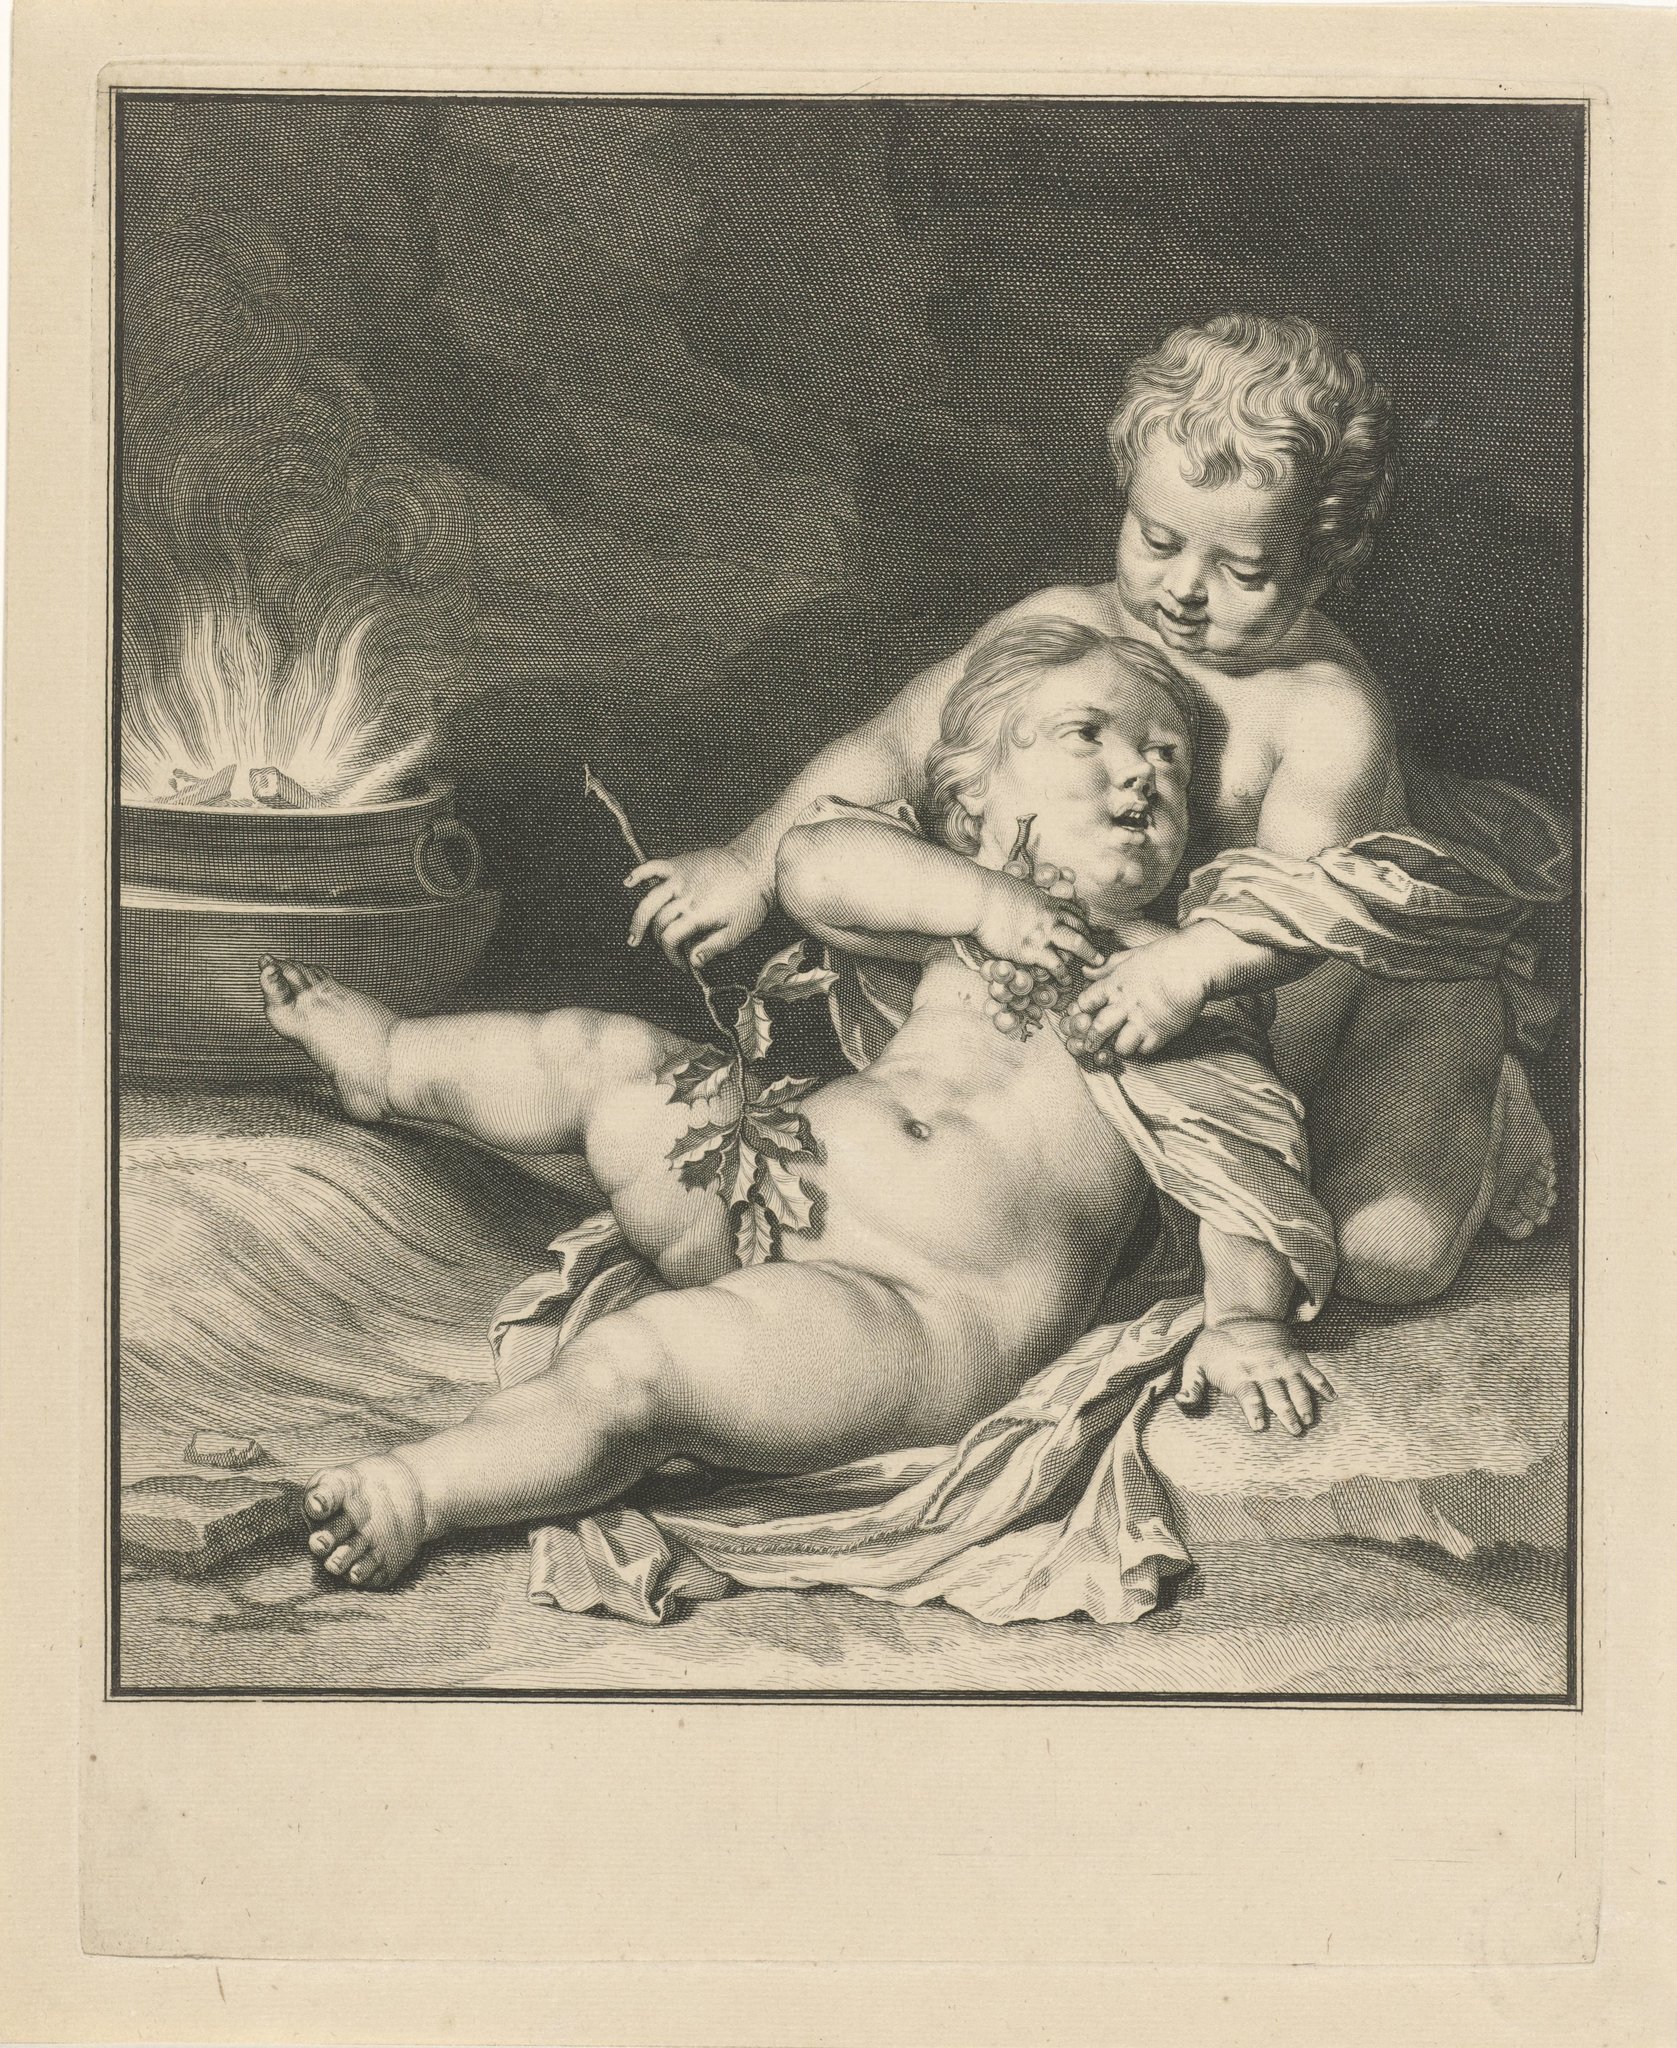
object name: print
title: Twee kinderen met druiventros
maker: jan van munnickhuysen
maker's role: draughtsman, print maker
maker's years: 1655-1701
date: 1664-1721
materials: paper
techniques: engraving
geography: netherlands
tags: children's bacchanal, warming oneself at a fire (or hearth, stove, fire-pan, brazier), cupids: 'amores', 'amoretti', 'putti', bunch of grapes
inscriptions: collector's mark: Lugt 240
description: Twee naakte kinderen bij een vuurpot. Het ene kind probeert druiven van de druiventros van de ander te ontfutselen.